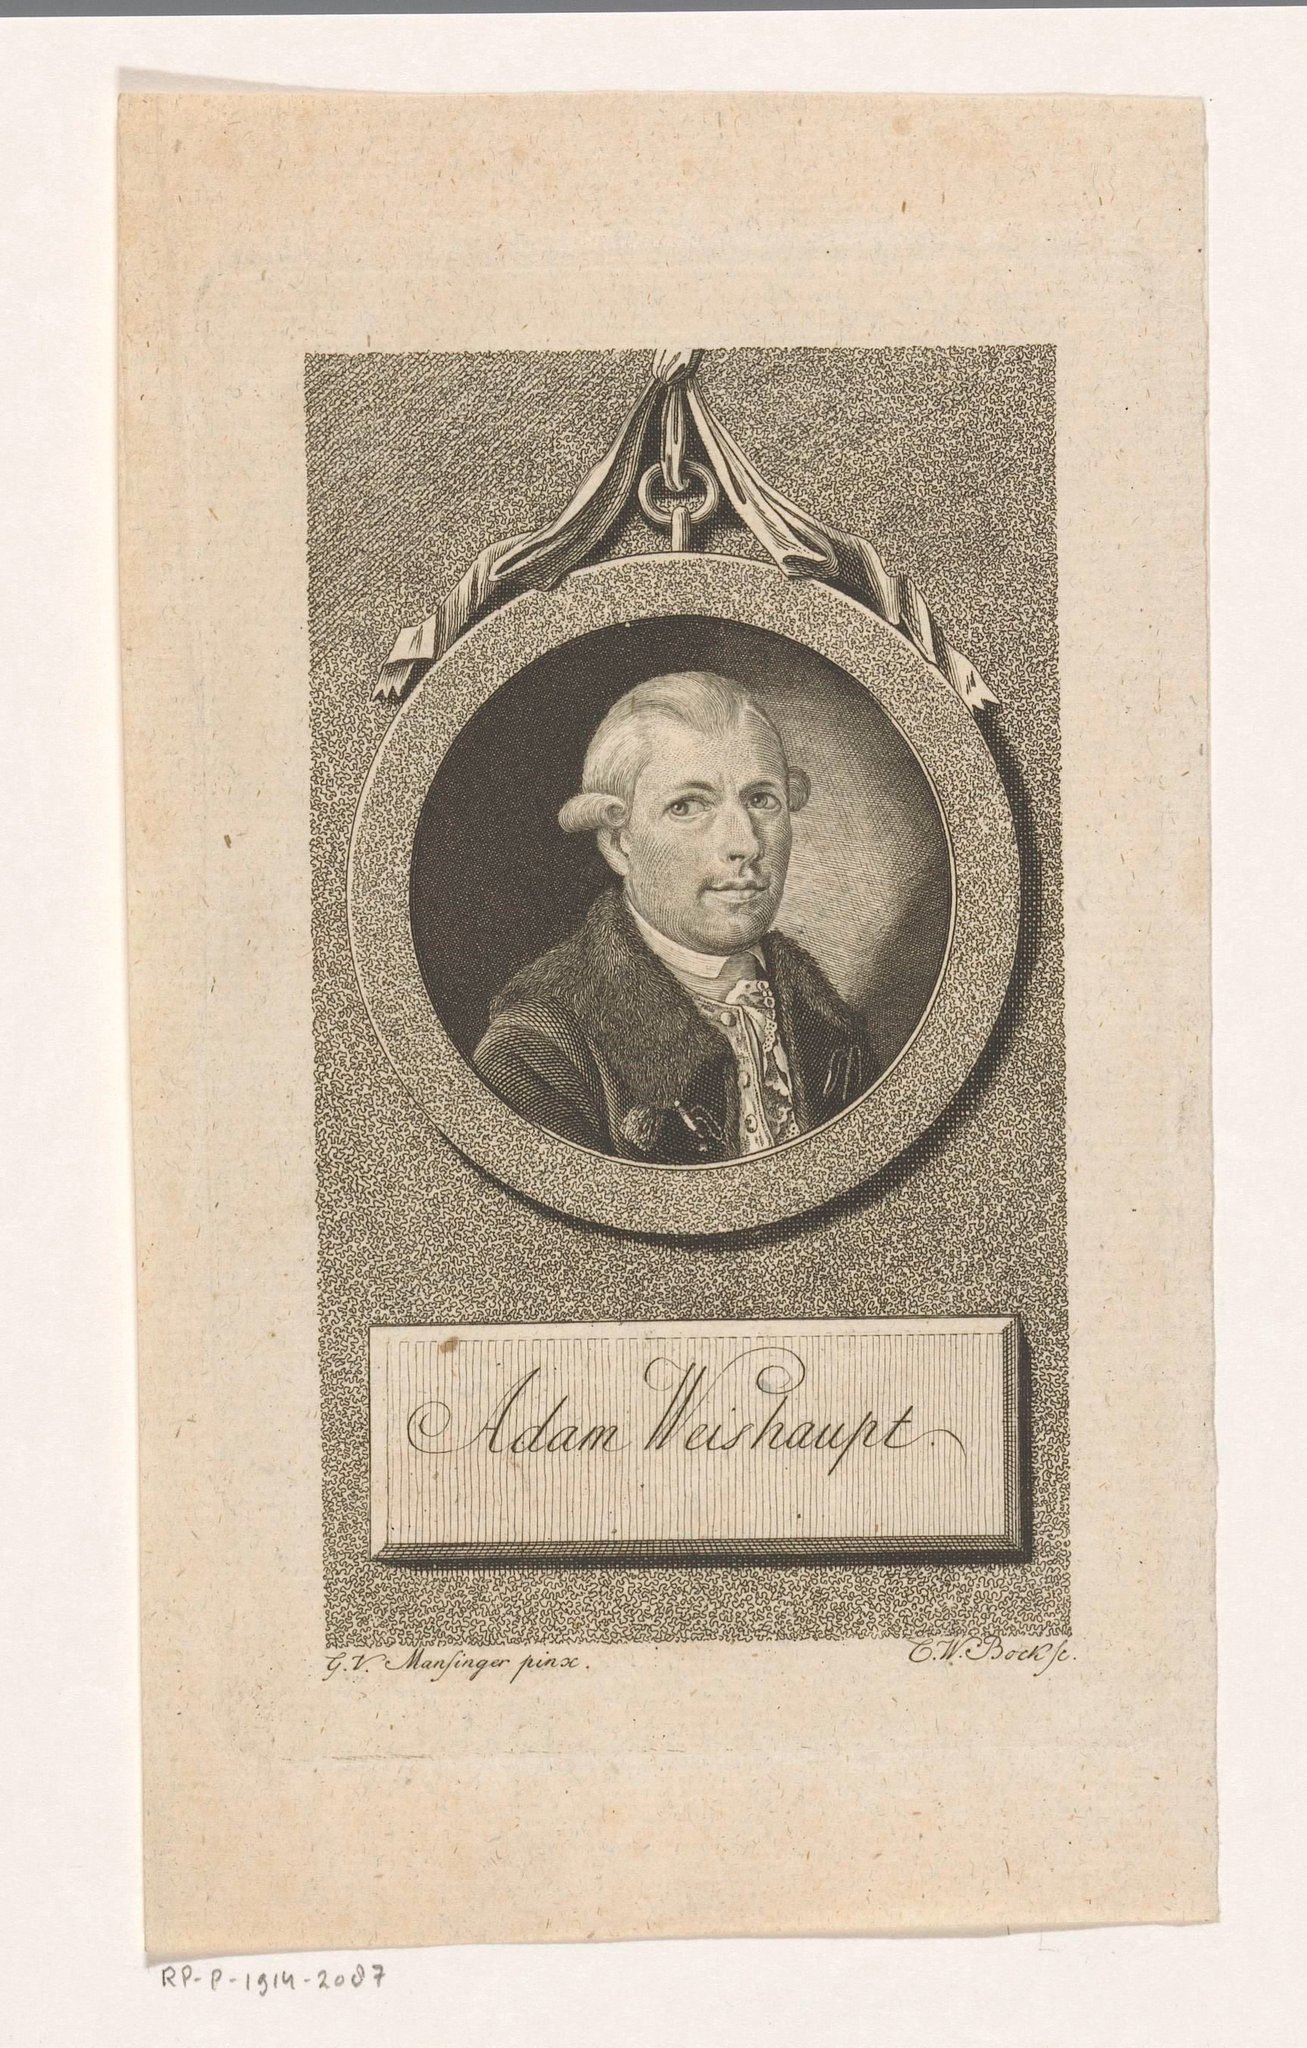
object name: print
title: Portret van Adam Weishaupt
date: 1765-1836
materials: paper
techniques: engraving, etching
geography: nuremberg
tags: historical persons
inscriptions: collector's mark: Lugt 2228